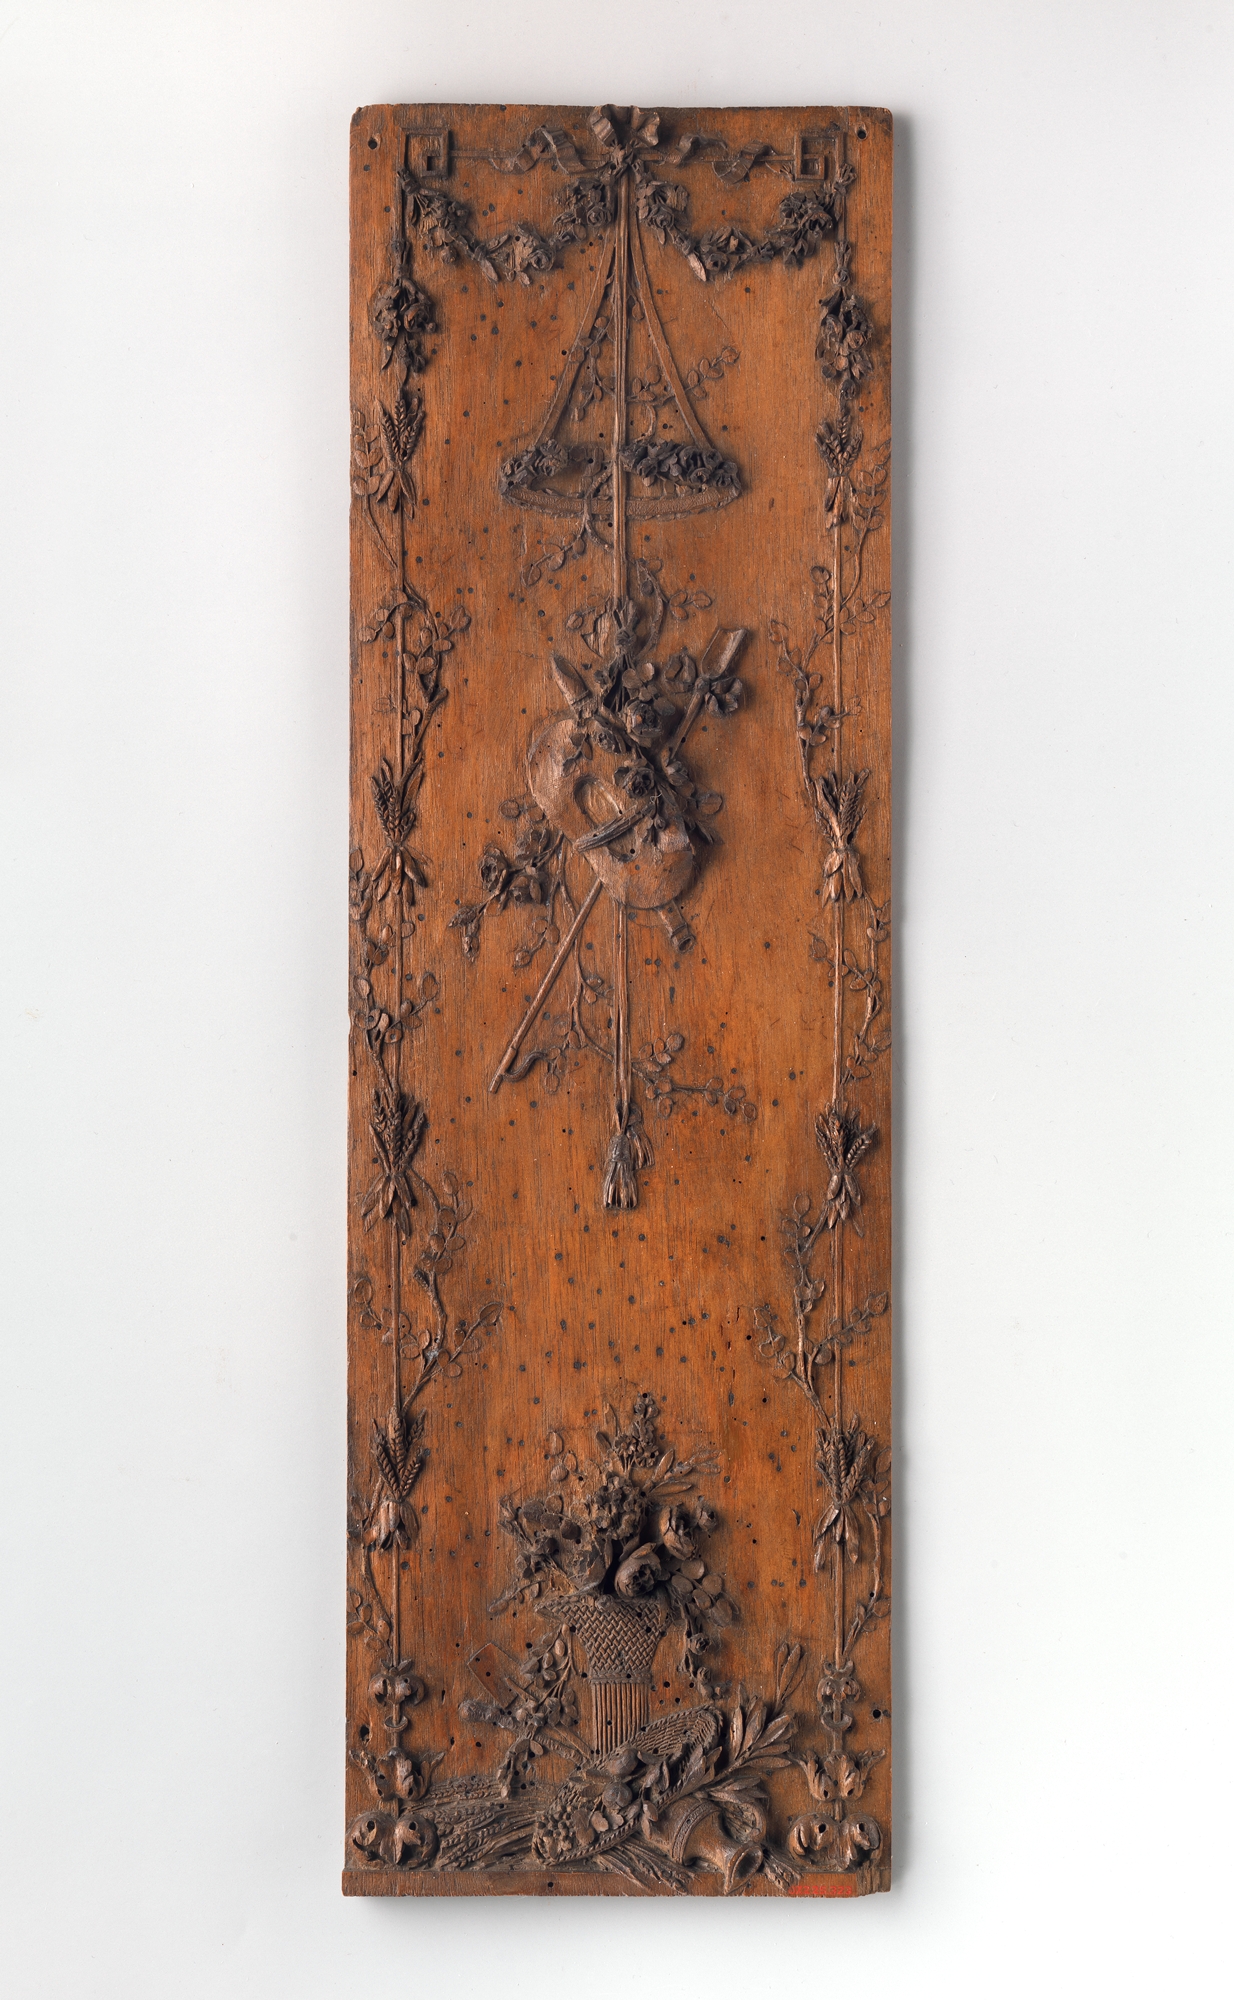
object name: panel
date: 1775-1785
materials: wood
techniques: carving